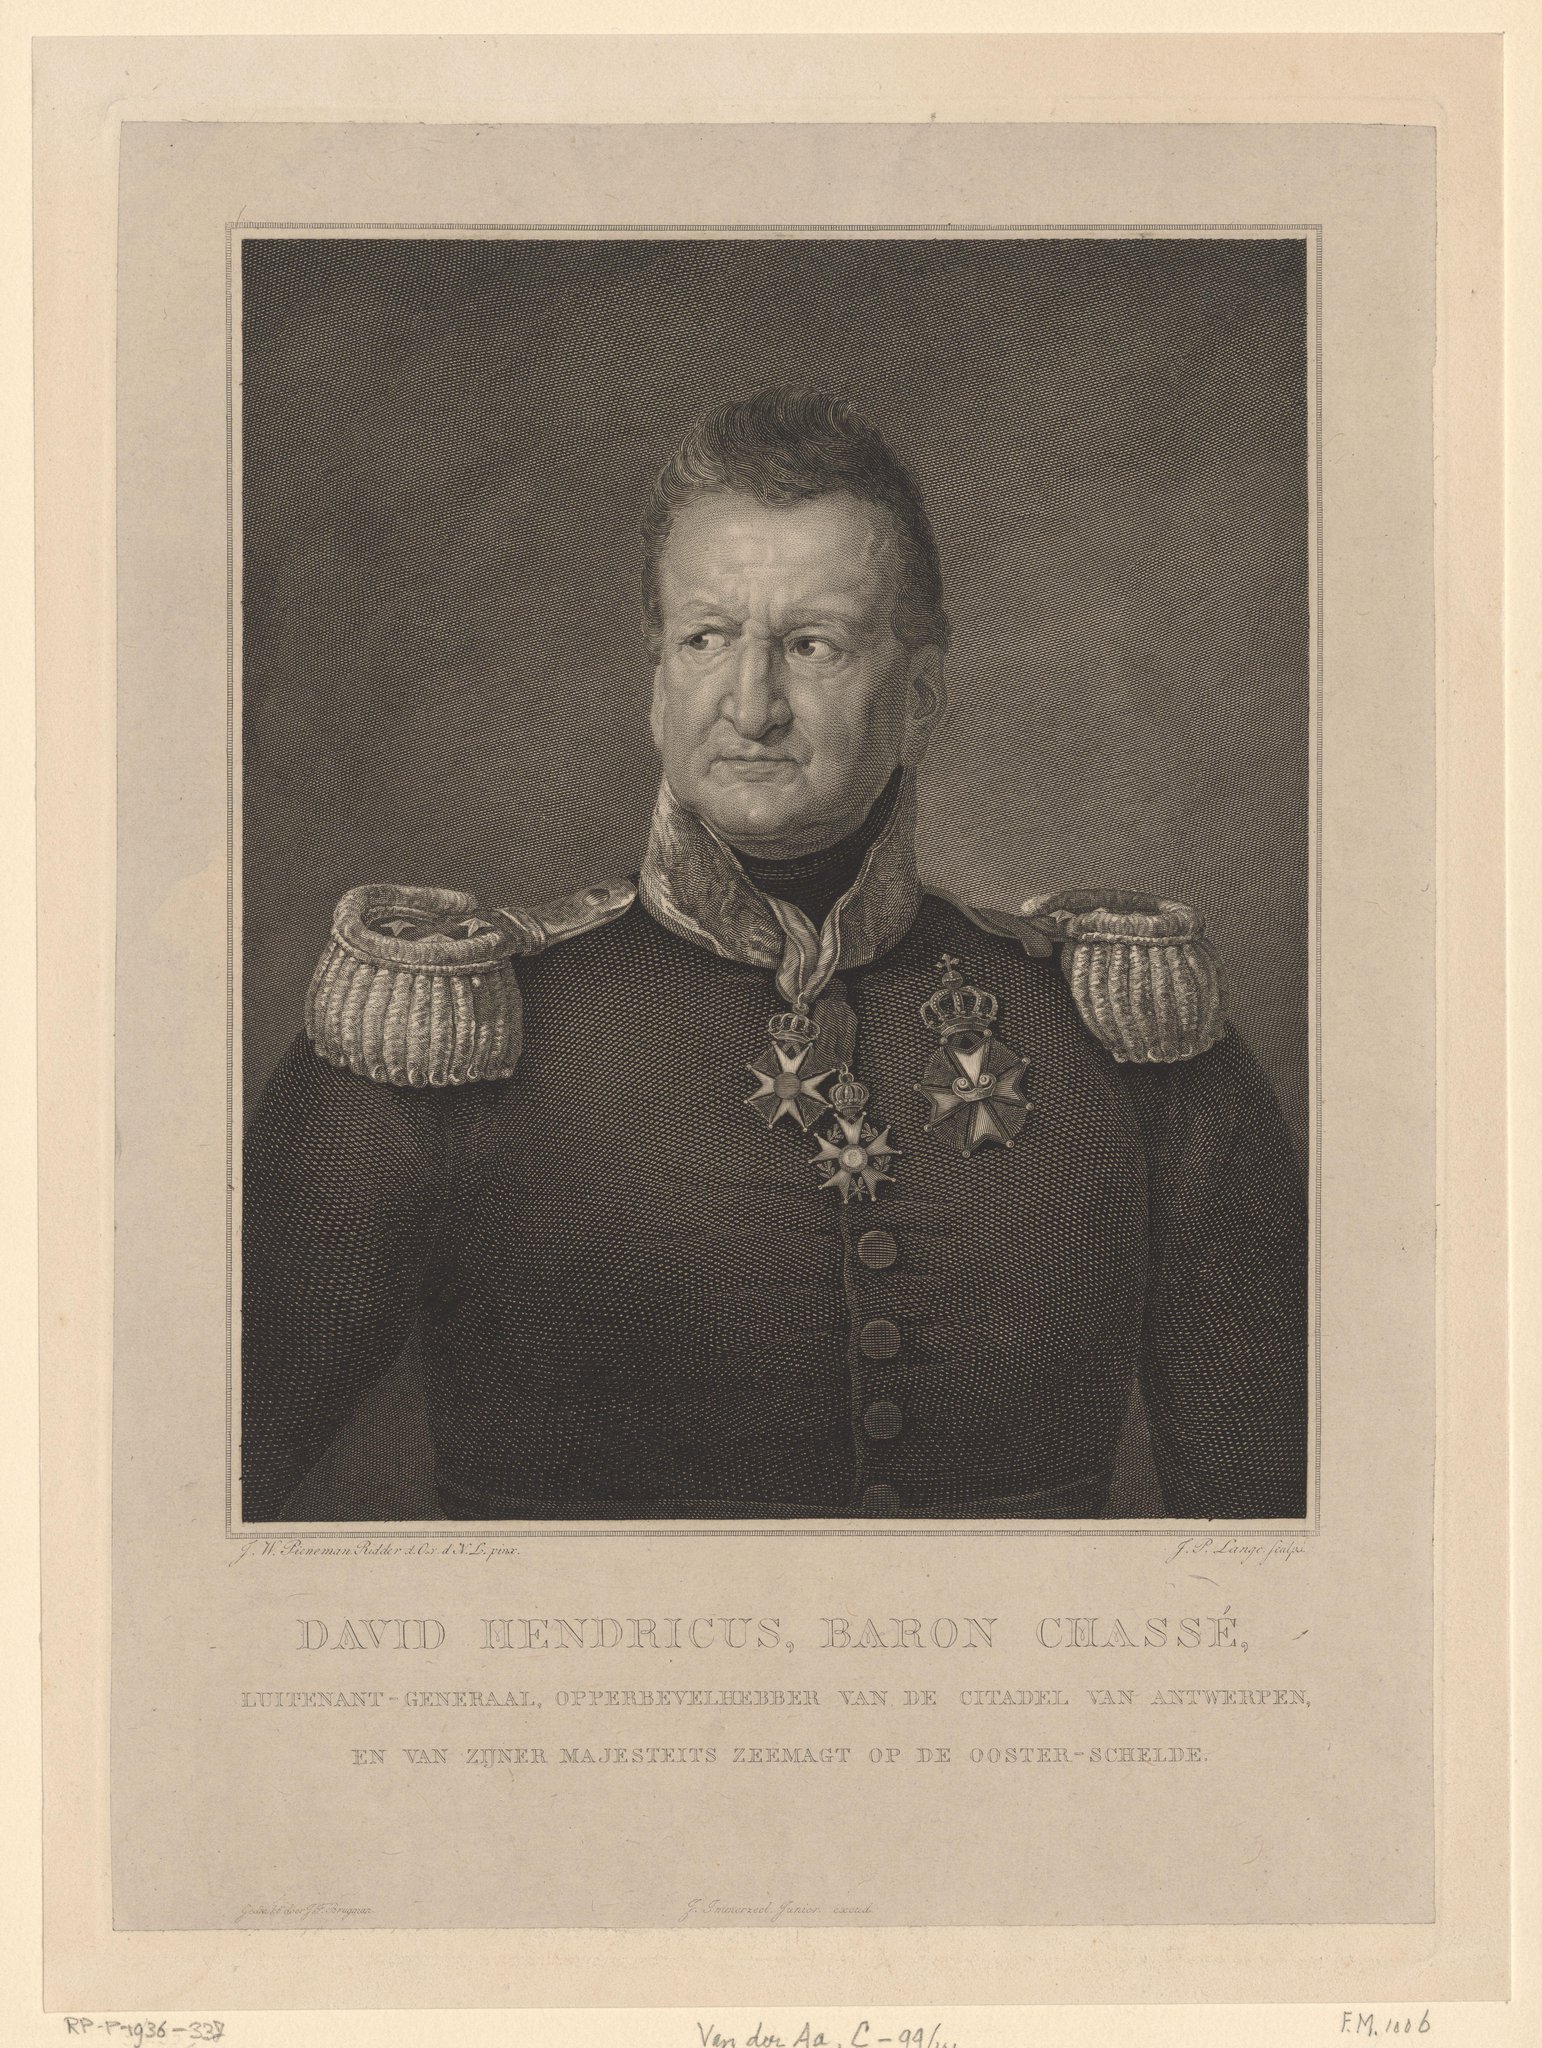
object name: print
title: Portret van David Hendrik baron Chassé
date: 1832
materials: paper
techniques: engraving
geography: amsterdam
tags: david hendrik baron chassé, historical persons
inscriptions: collector's mark: Lugt 2282